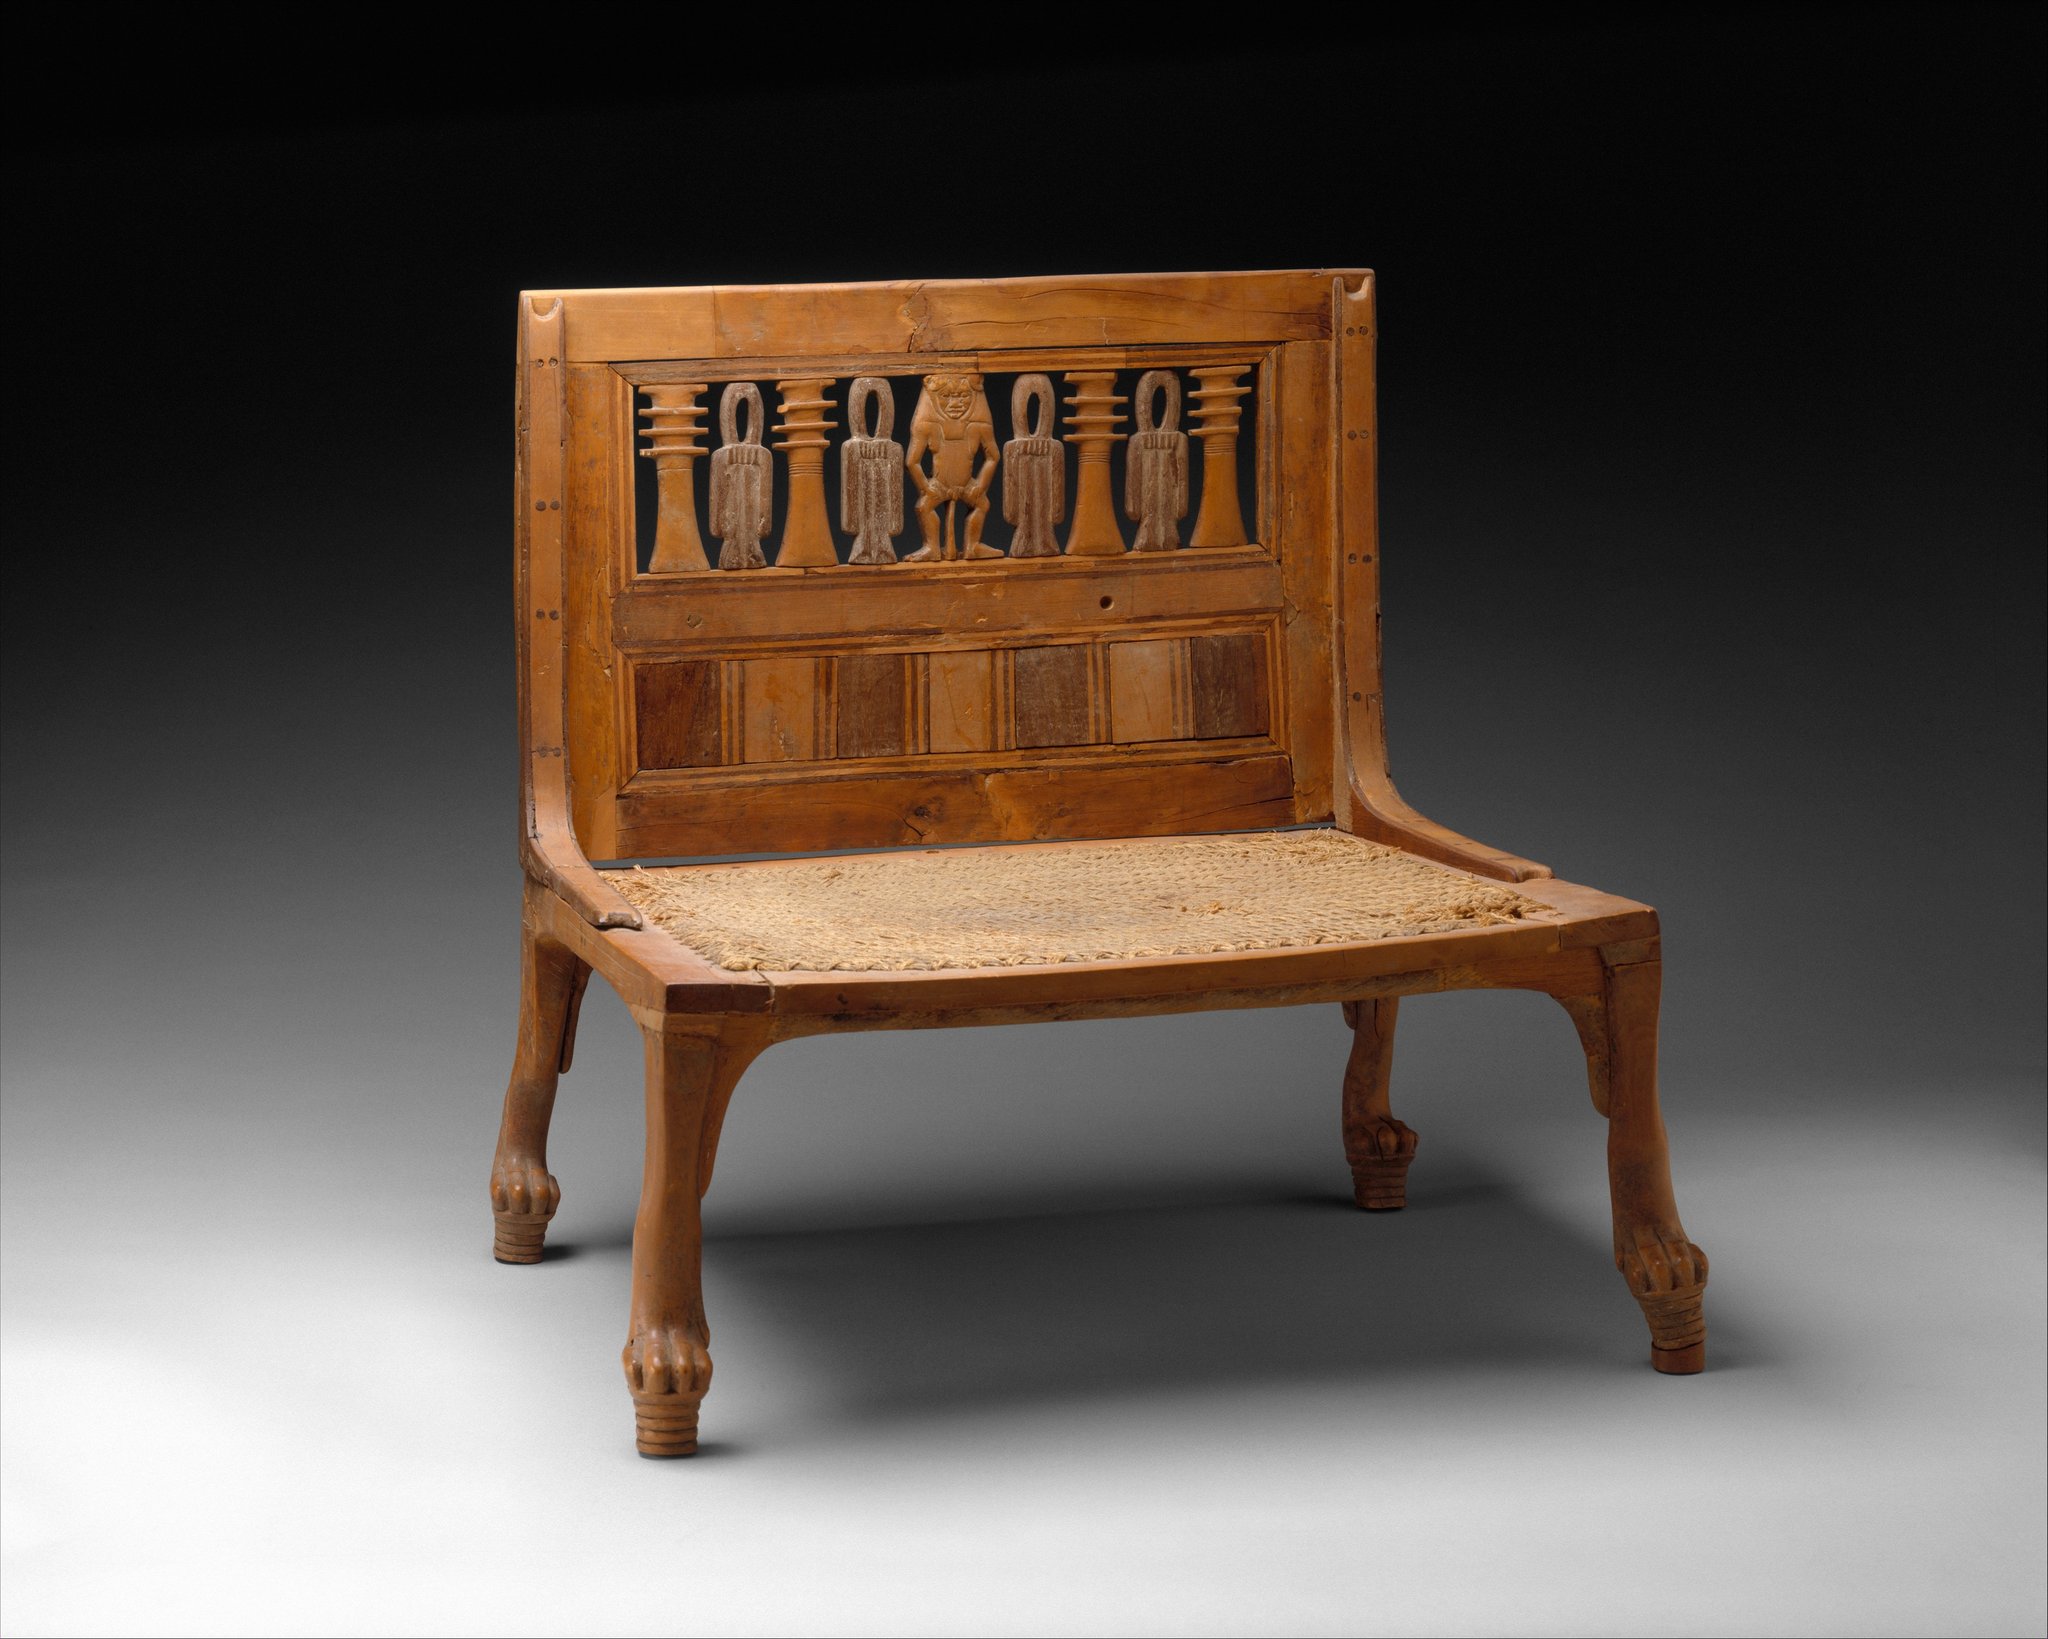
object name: chair, hatnefer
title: Hatnefer's Chair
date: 1492-1473 BCE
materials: wood, cord, linen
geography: egypt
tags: bes,isis